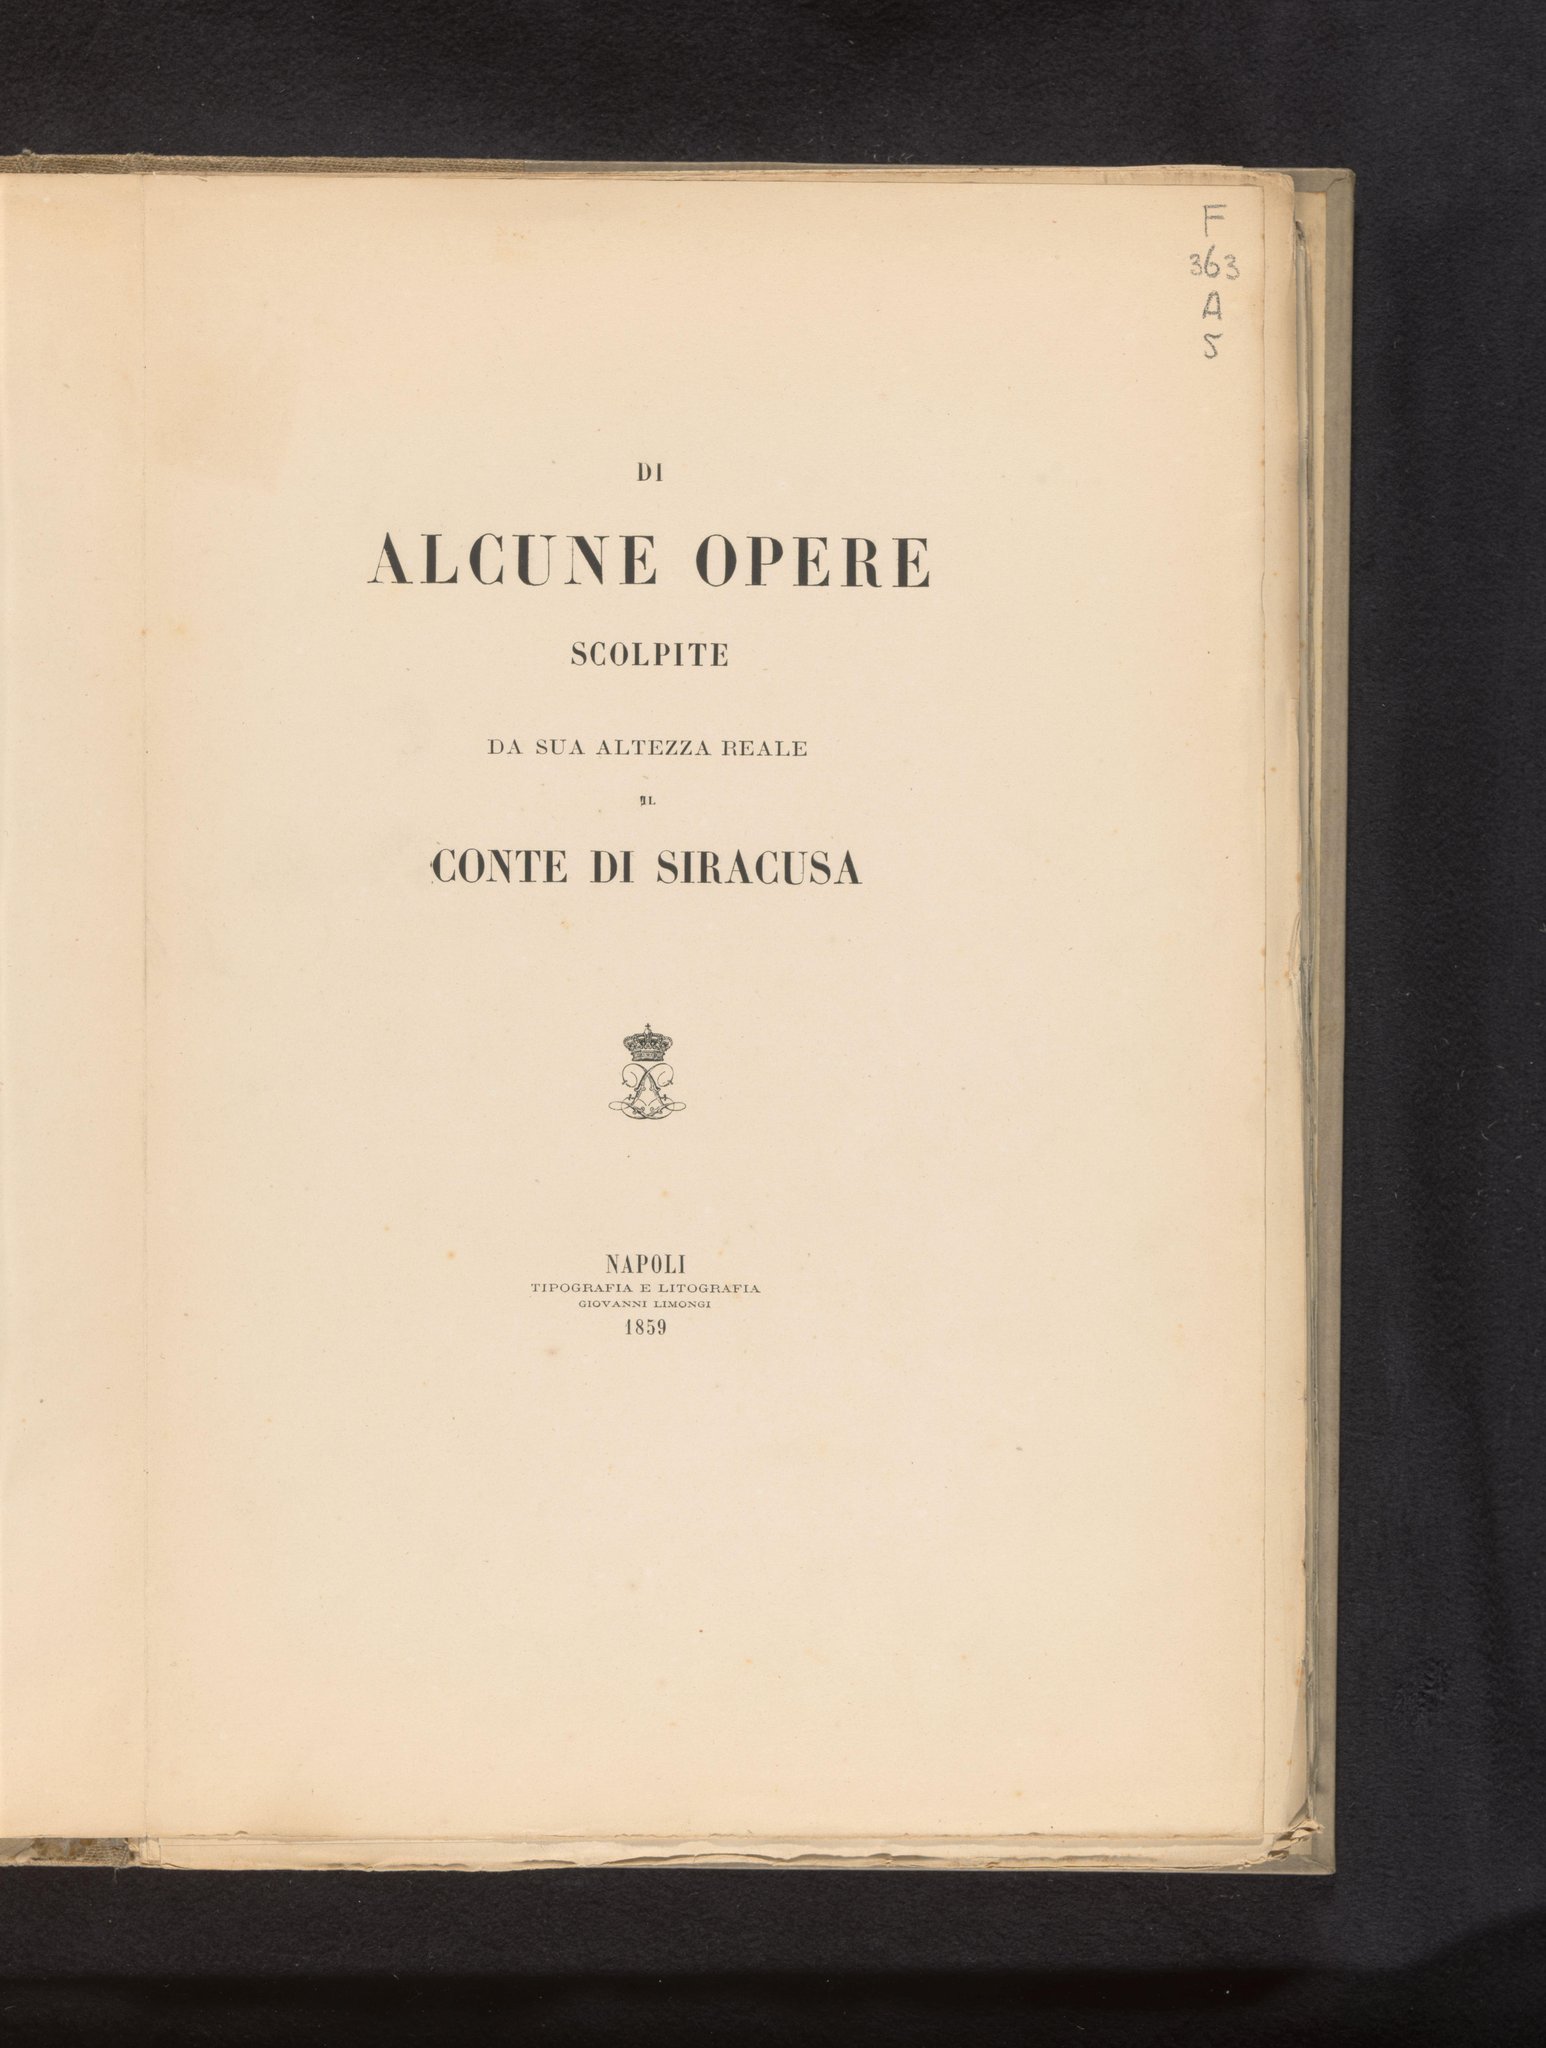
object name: wrapper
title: Di alcune opere scolpite da sua altezza reale il Conte di Siracusa / [Luigi Indelli (...) et al.]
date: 1859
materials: cardboard, linen, paper, photographic support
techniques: albumen print, printing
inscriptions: bookplate: ‘Ex libris Ugo Ojetti’, date: ‘JUNE/ 1995’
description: Omslag met 18 foto's op 18 bladen en 14 tekstbladen.